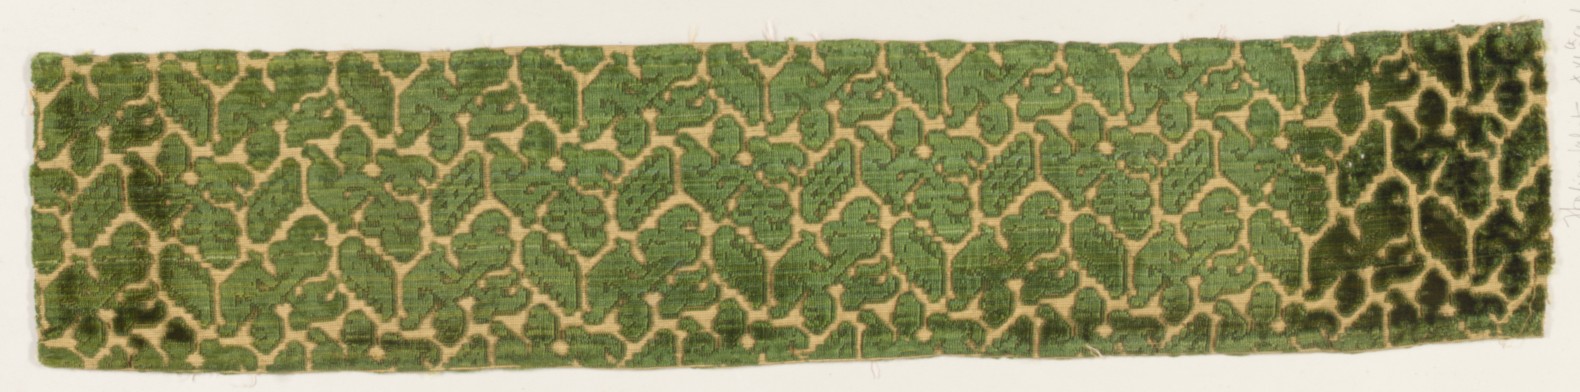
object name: fragment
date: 1501-1600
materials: silk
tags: leaves